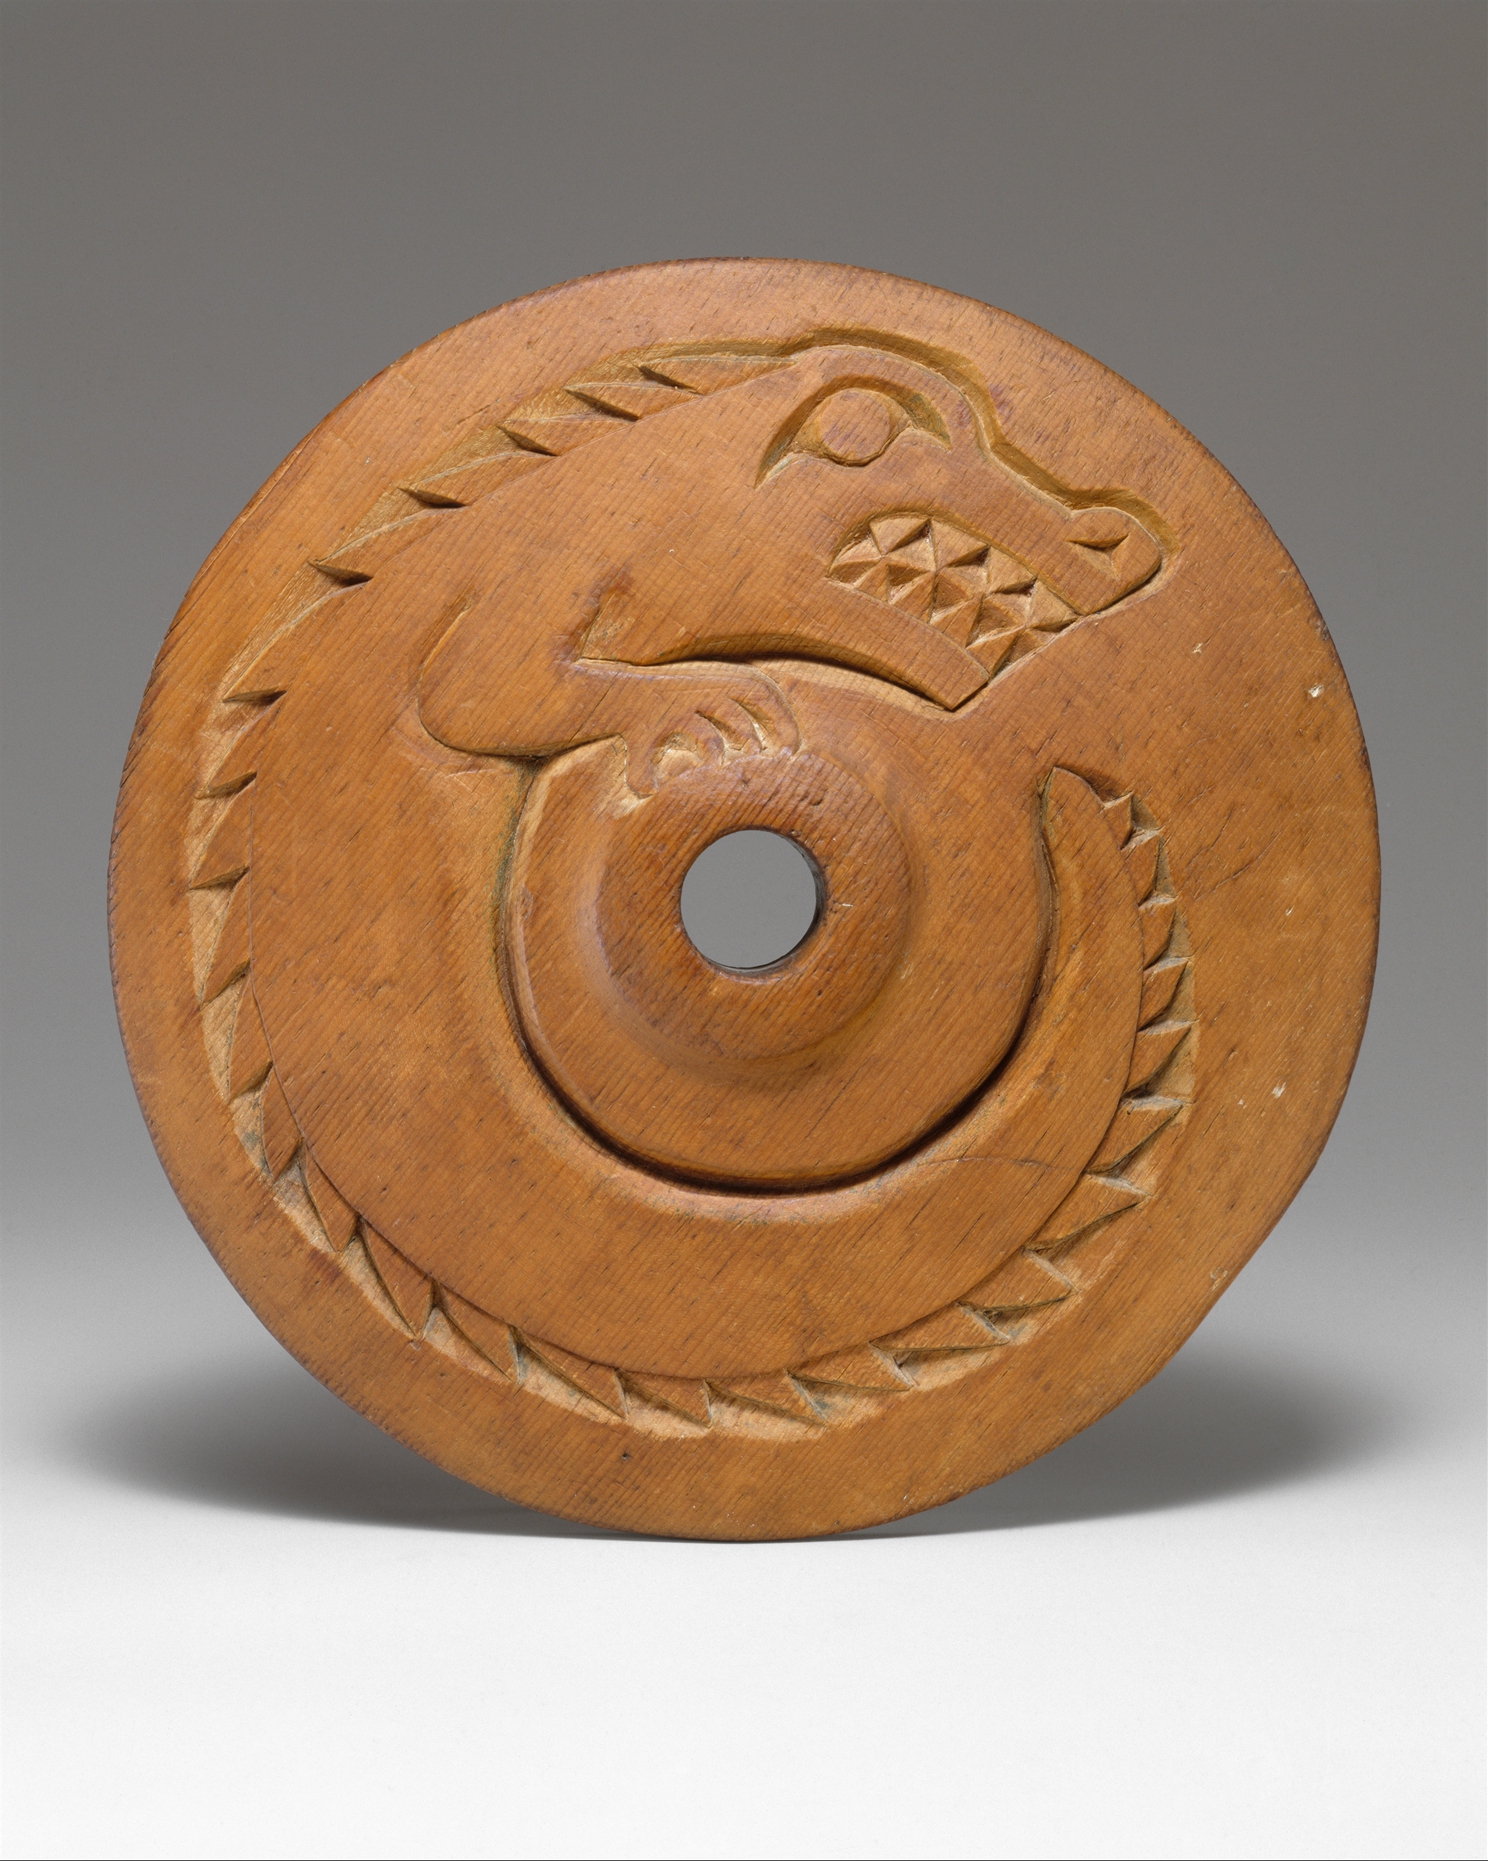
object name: spindle whorl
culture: salish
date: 1860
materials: wood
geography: canada